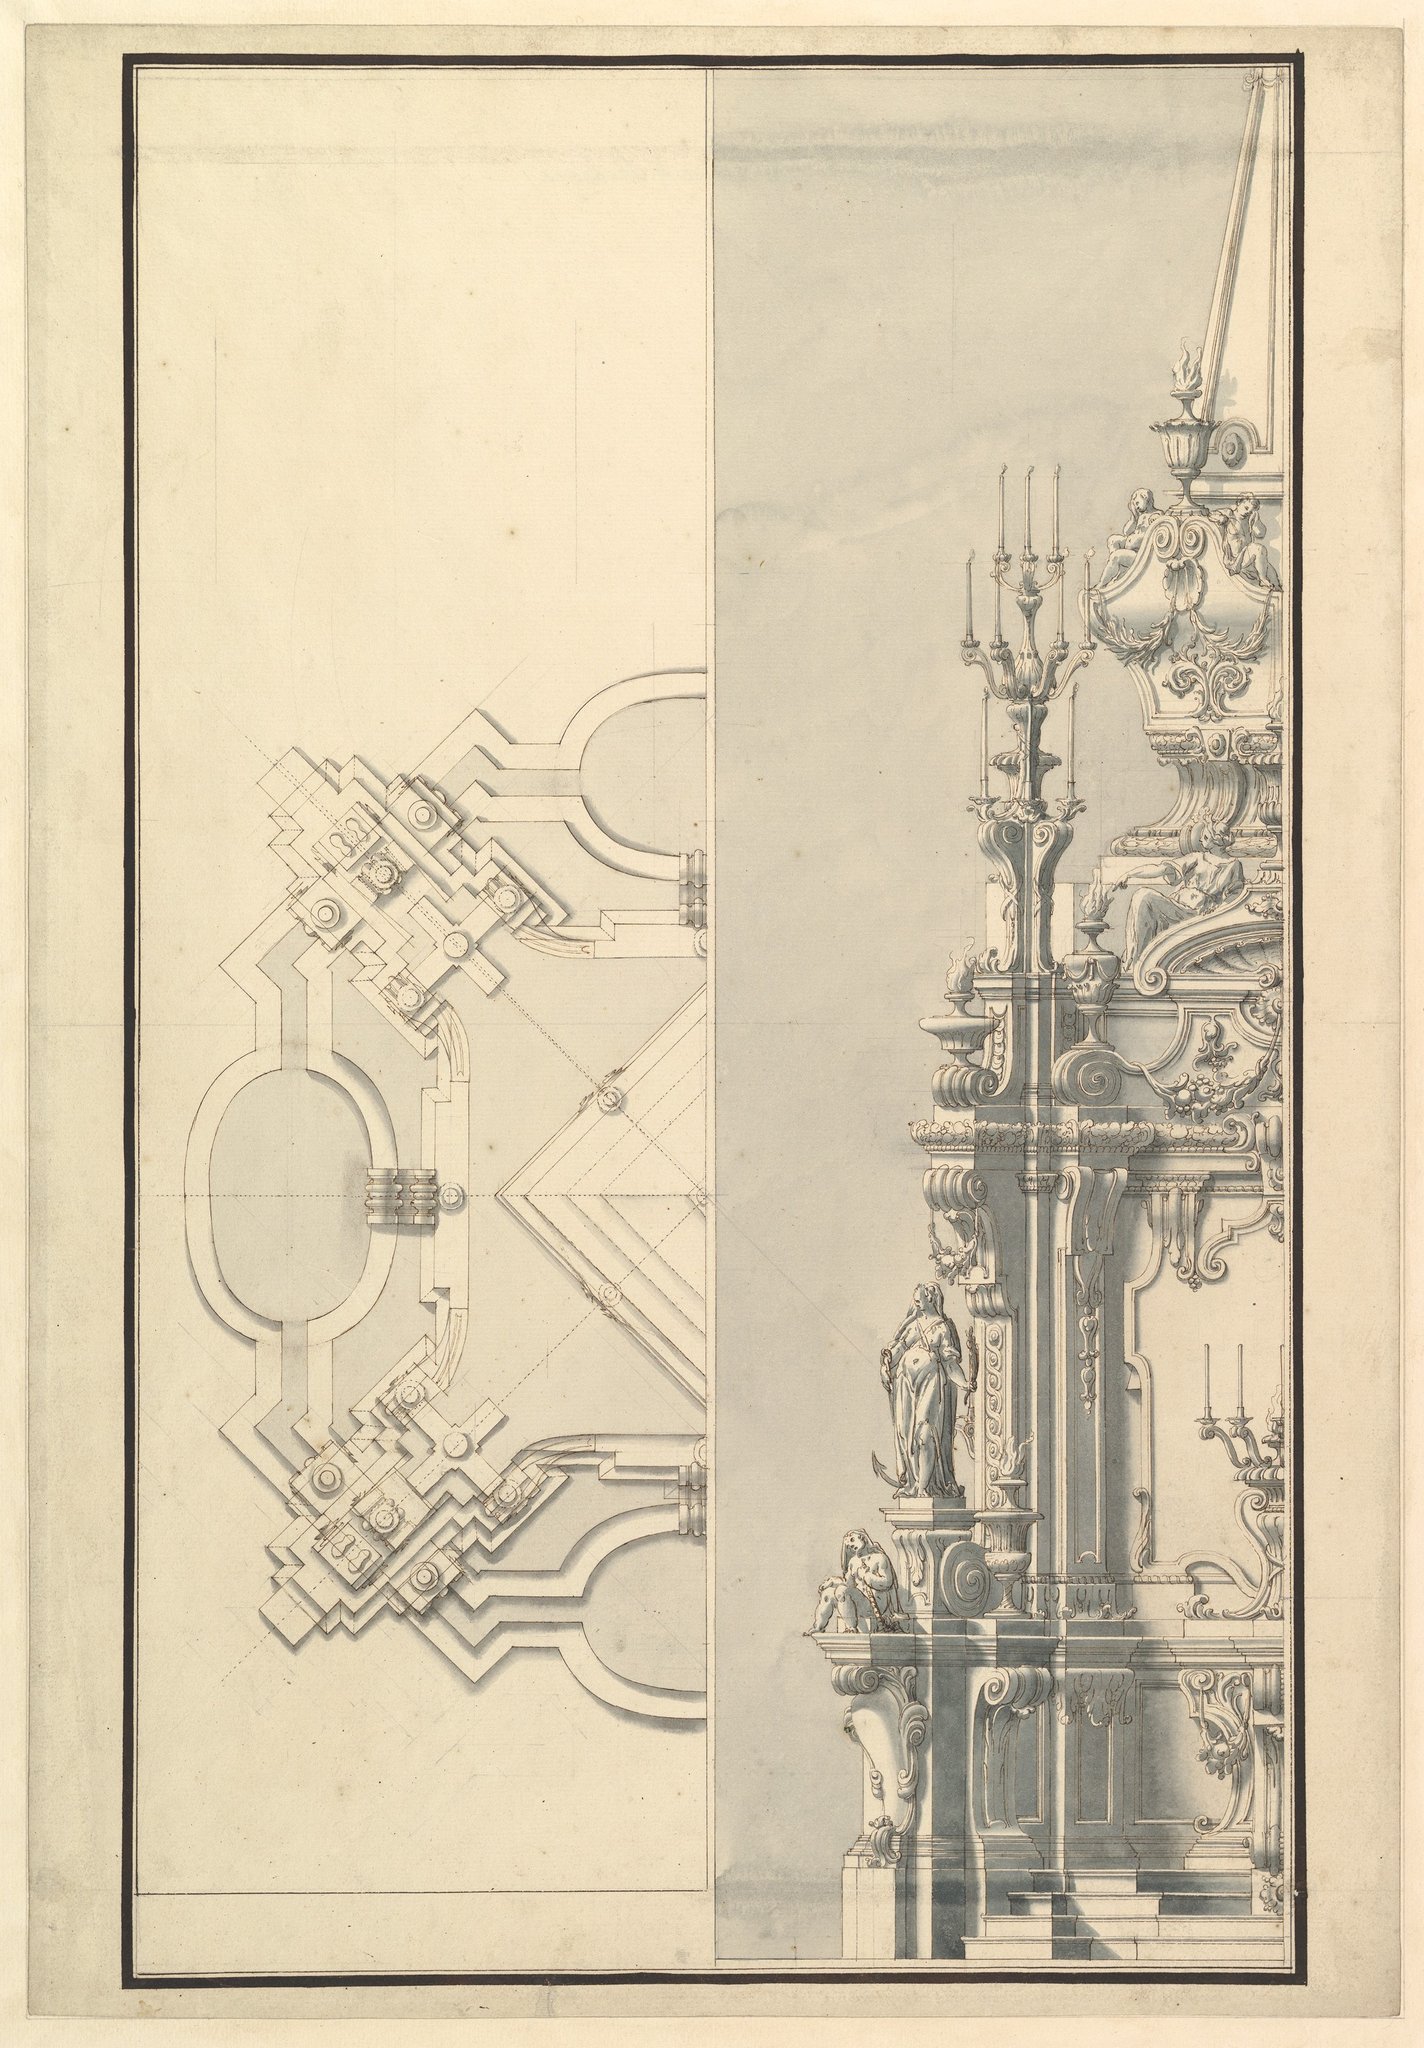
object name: drawing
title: Half Ground Plan and Half Elevation for a Catafalque for a Queen of Sardinia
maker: giuseppe galli bibiena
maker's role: artist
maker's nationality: italian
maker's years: 1696-1756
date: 1696-1756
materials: ink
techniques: pen, wash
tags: architecture